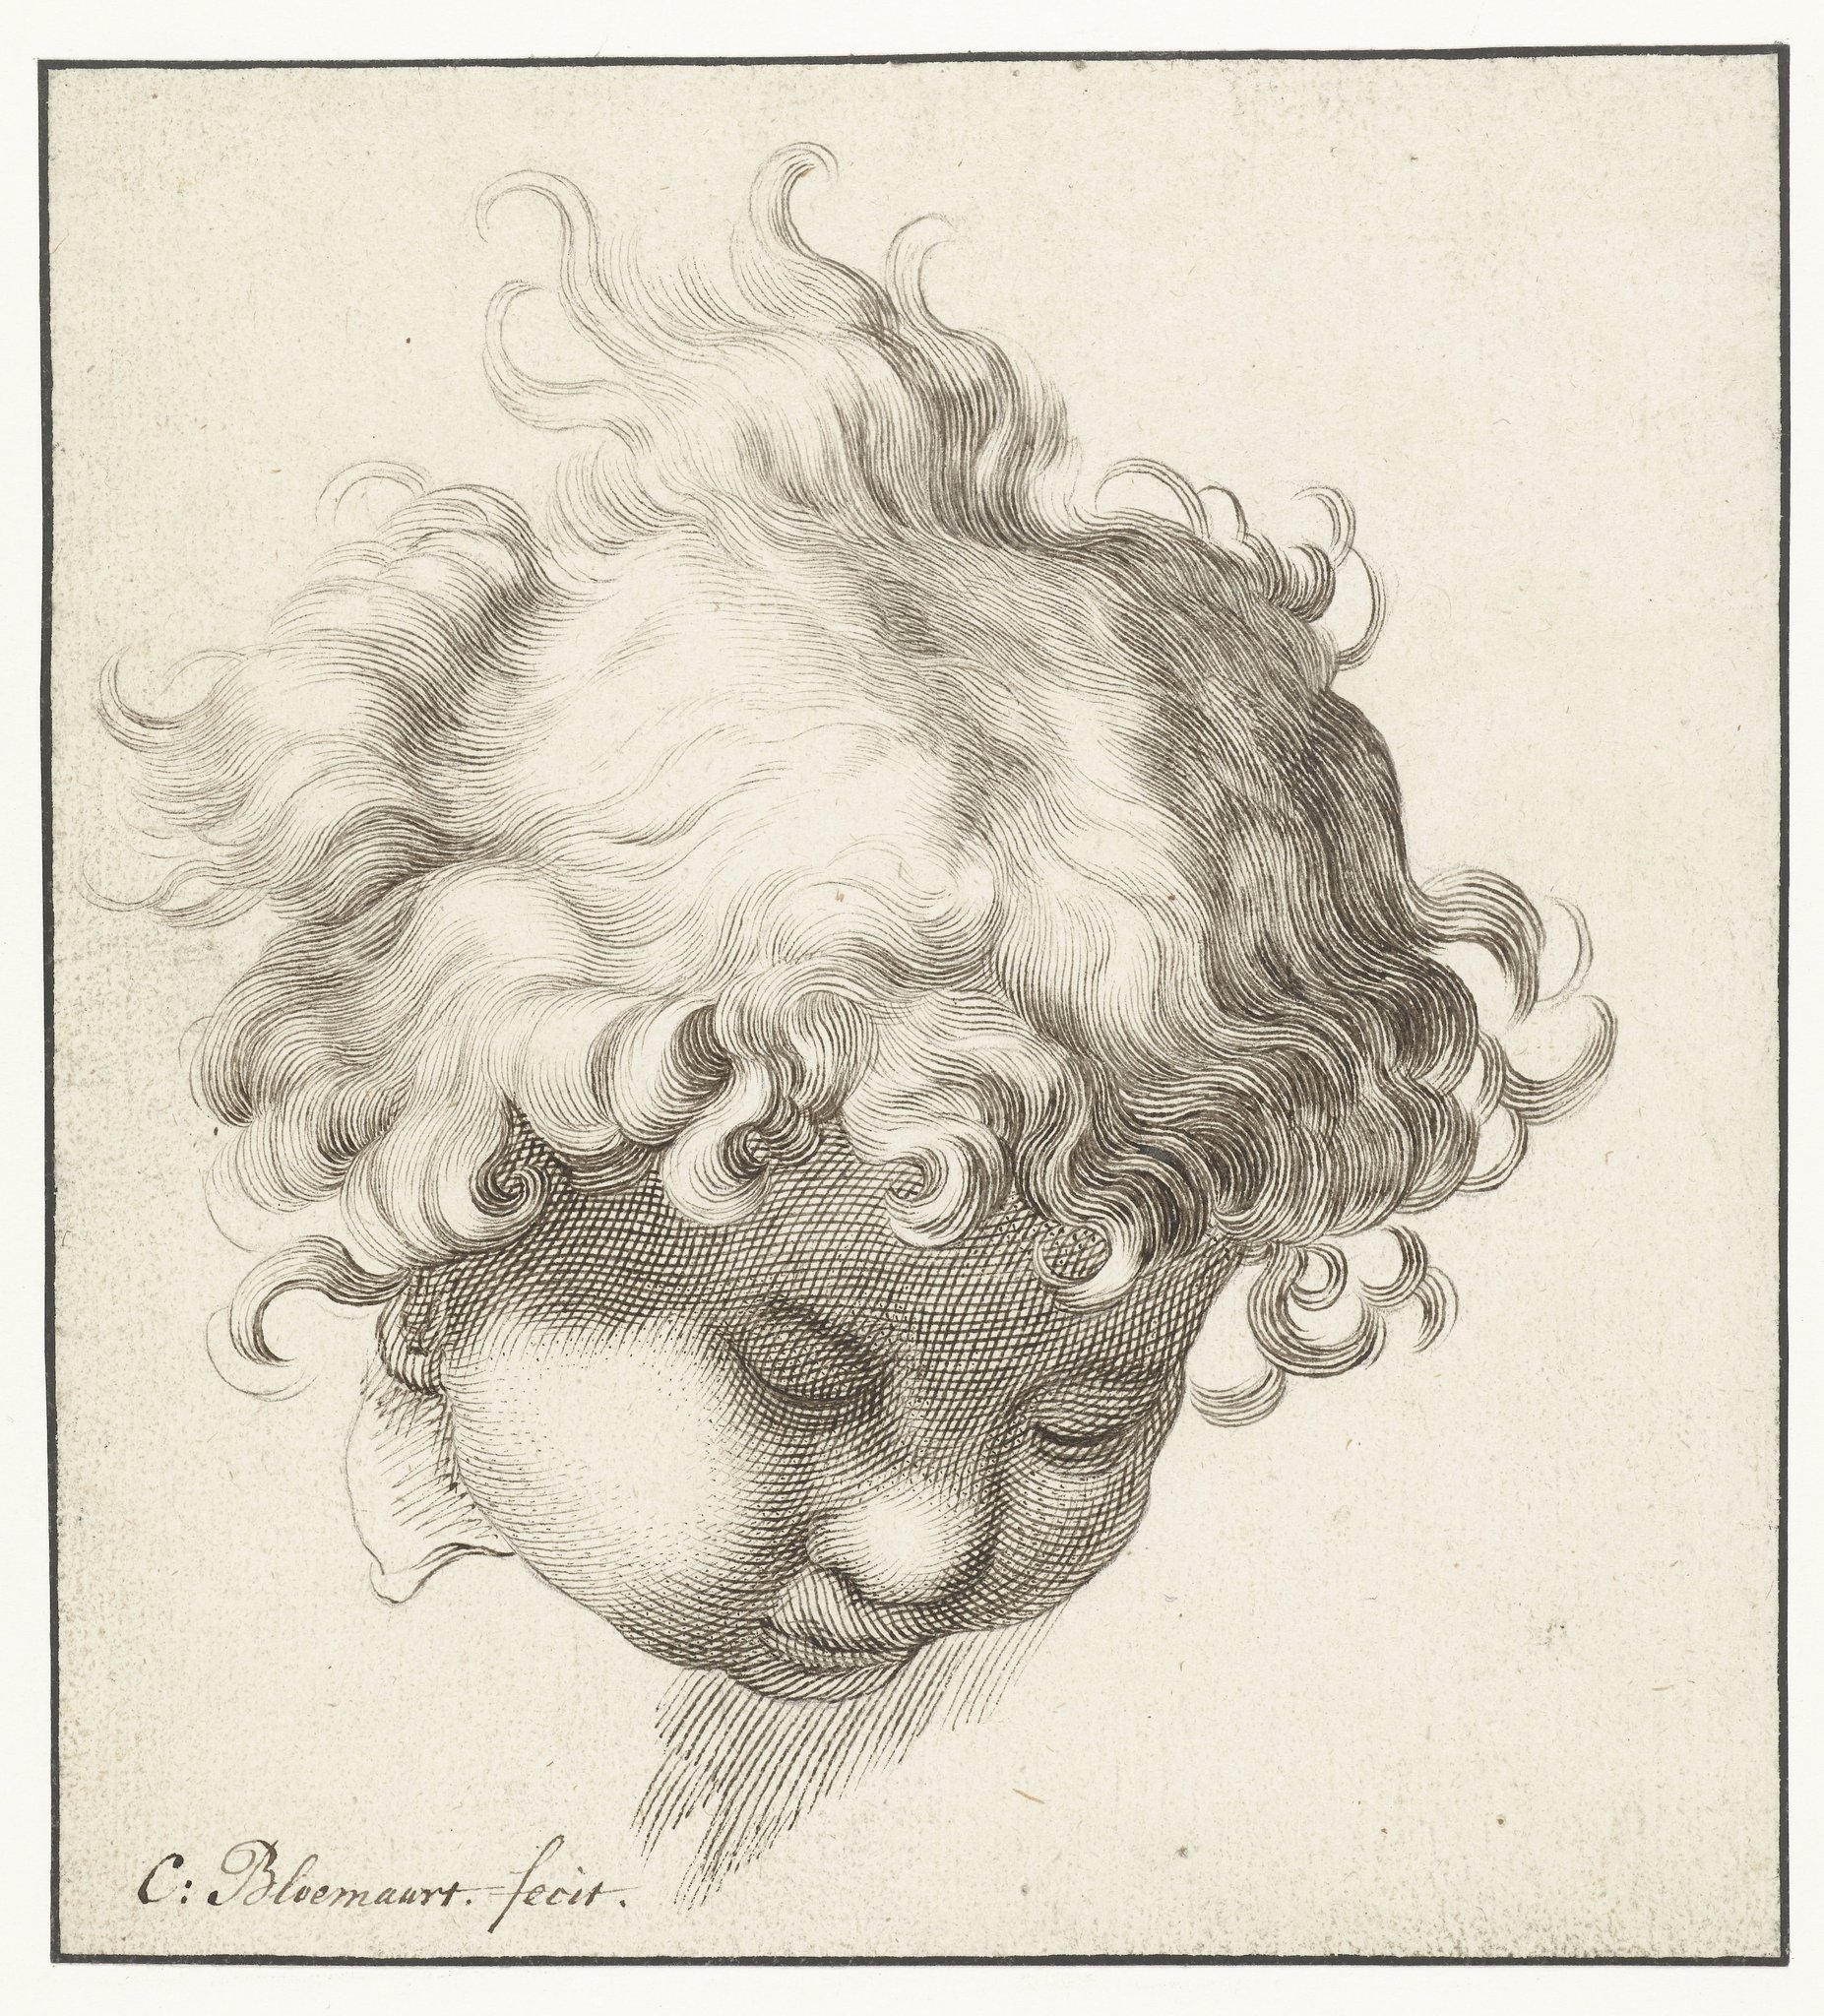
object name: drawing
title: Hoofd van een jongen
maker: Anonymous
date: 1574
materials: ink, paper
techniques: pen